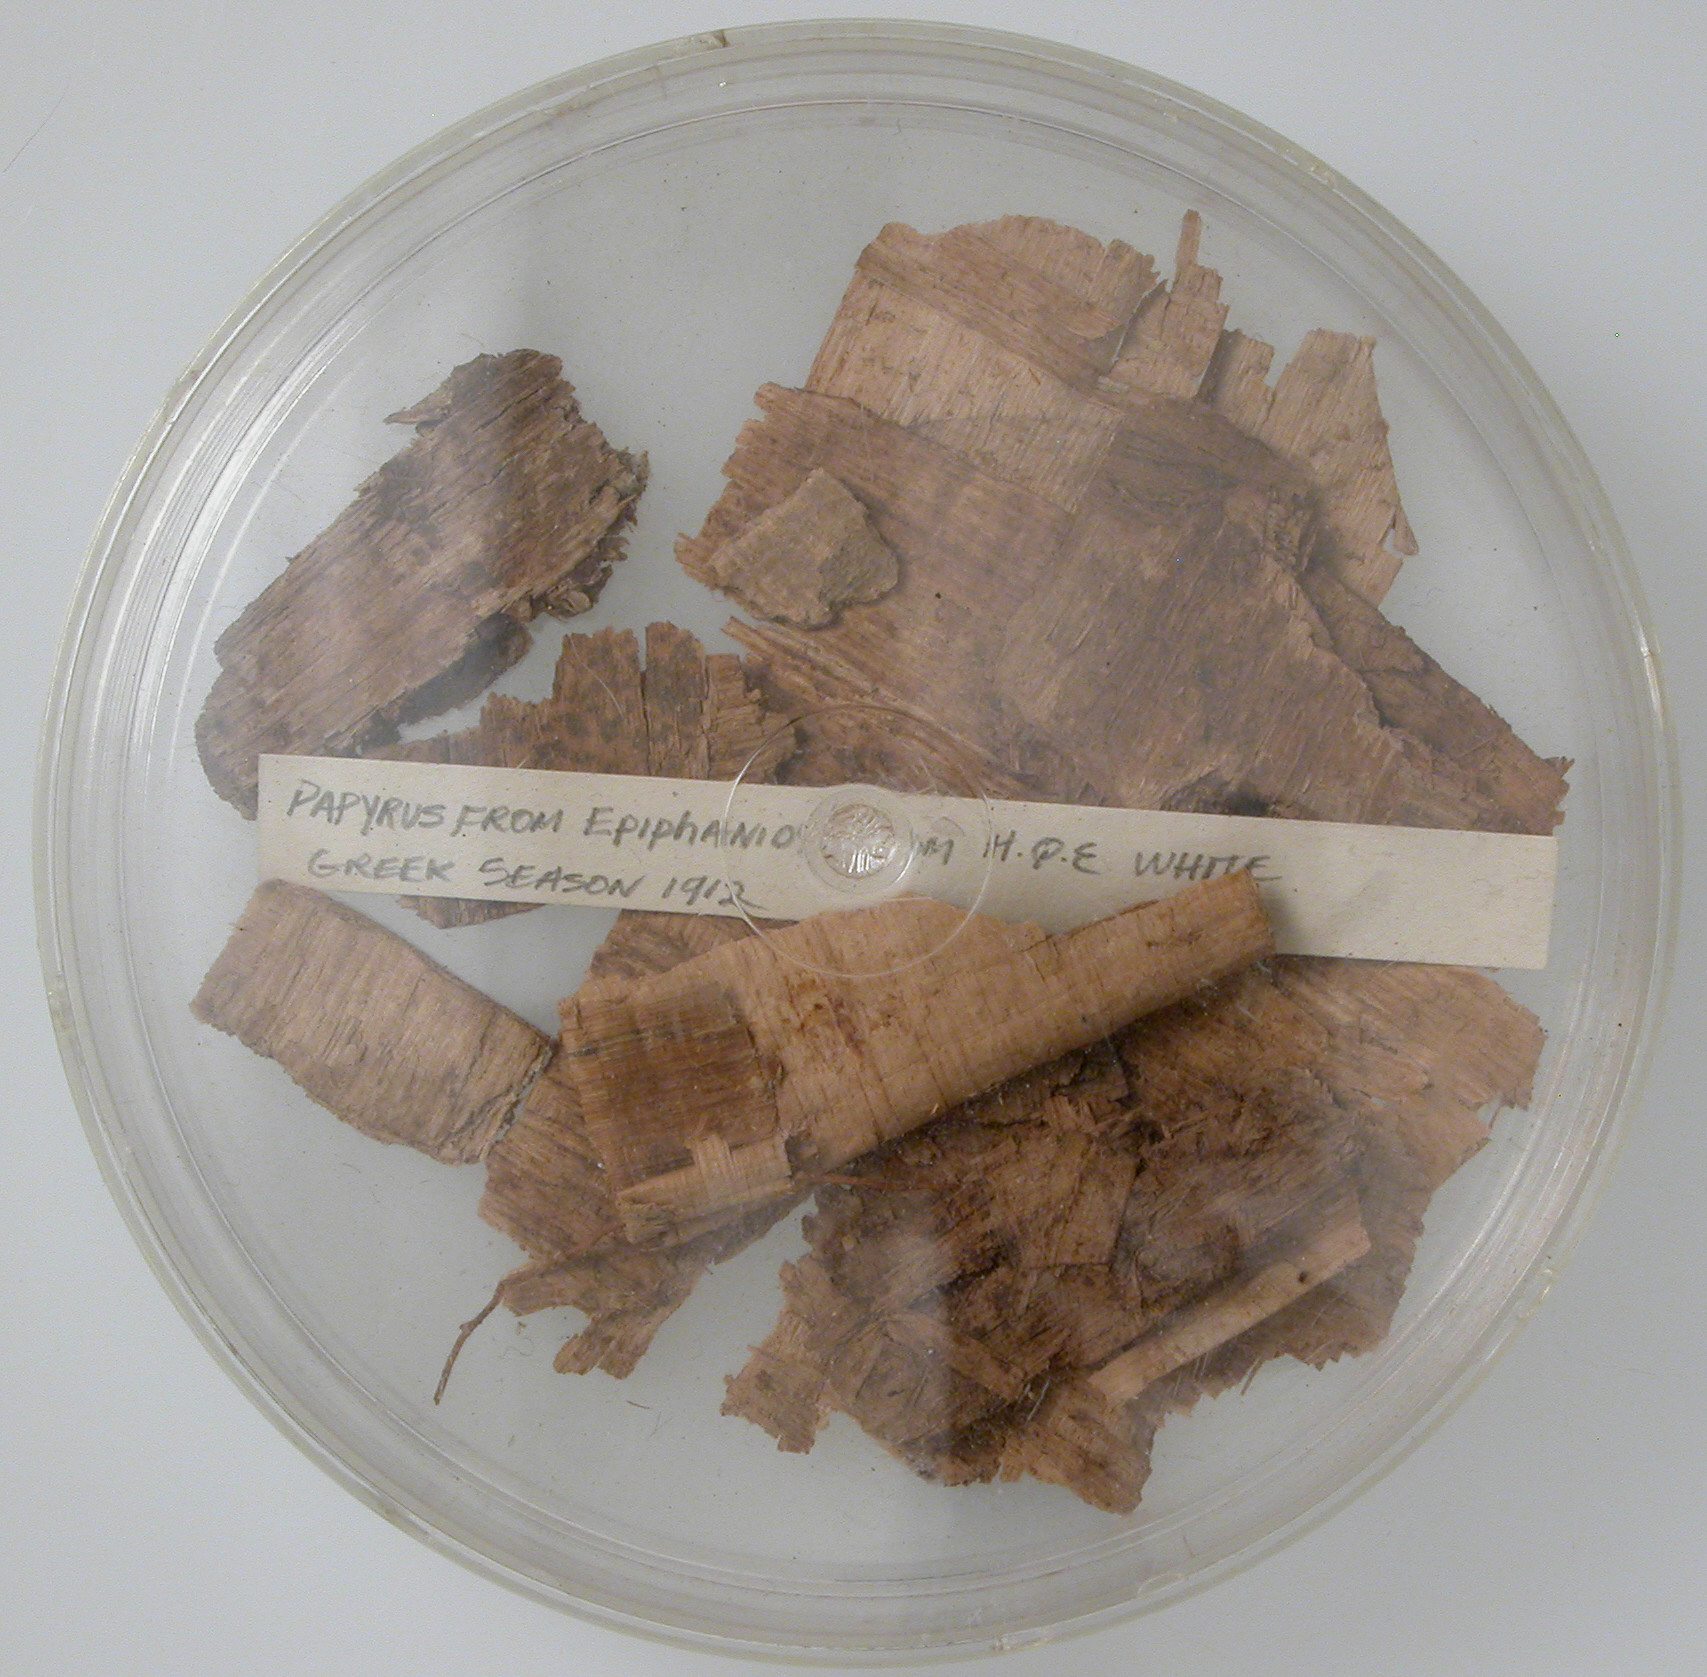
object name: fragment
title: Papyri Fragments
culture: coptic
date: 601-700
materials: ink, papyrus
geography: egypt